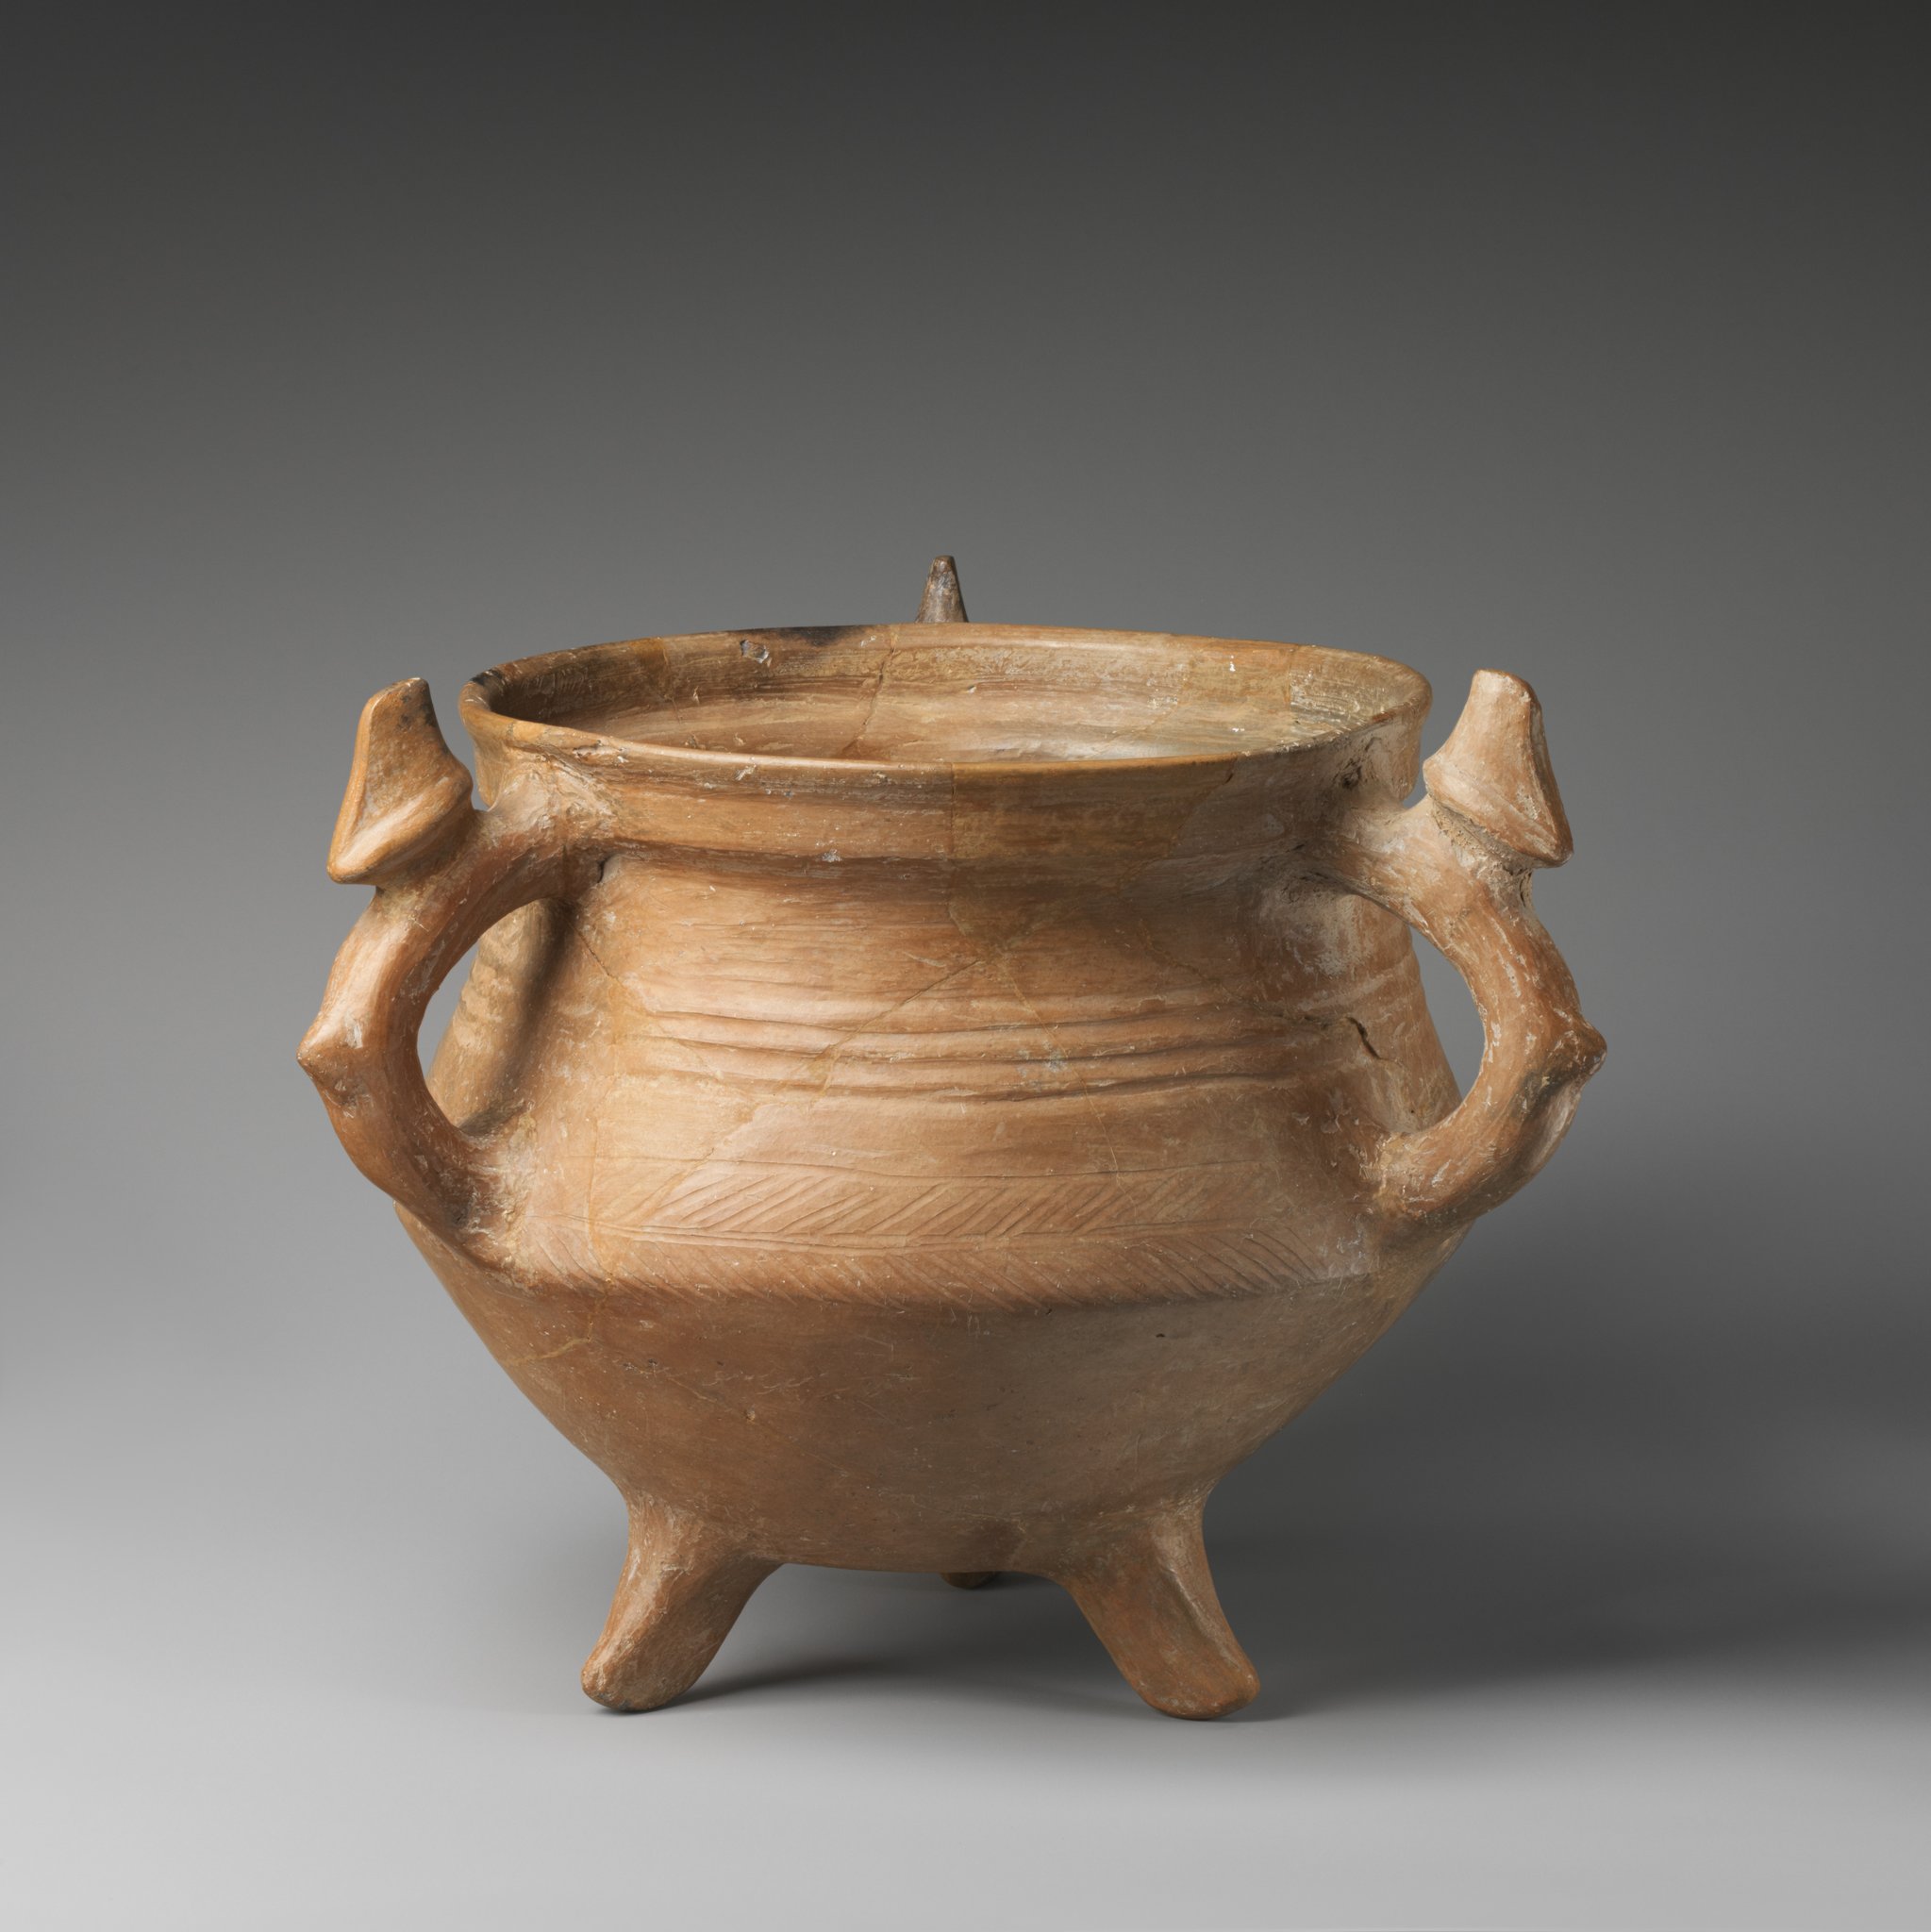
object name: vessel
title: Tripod vessel with three animal-shaped handles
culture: iranian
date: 900-801 BCE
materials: ceramic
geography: iran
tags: animals